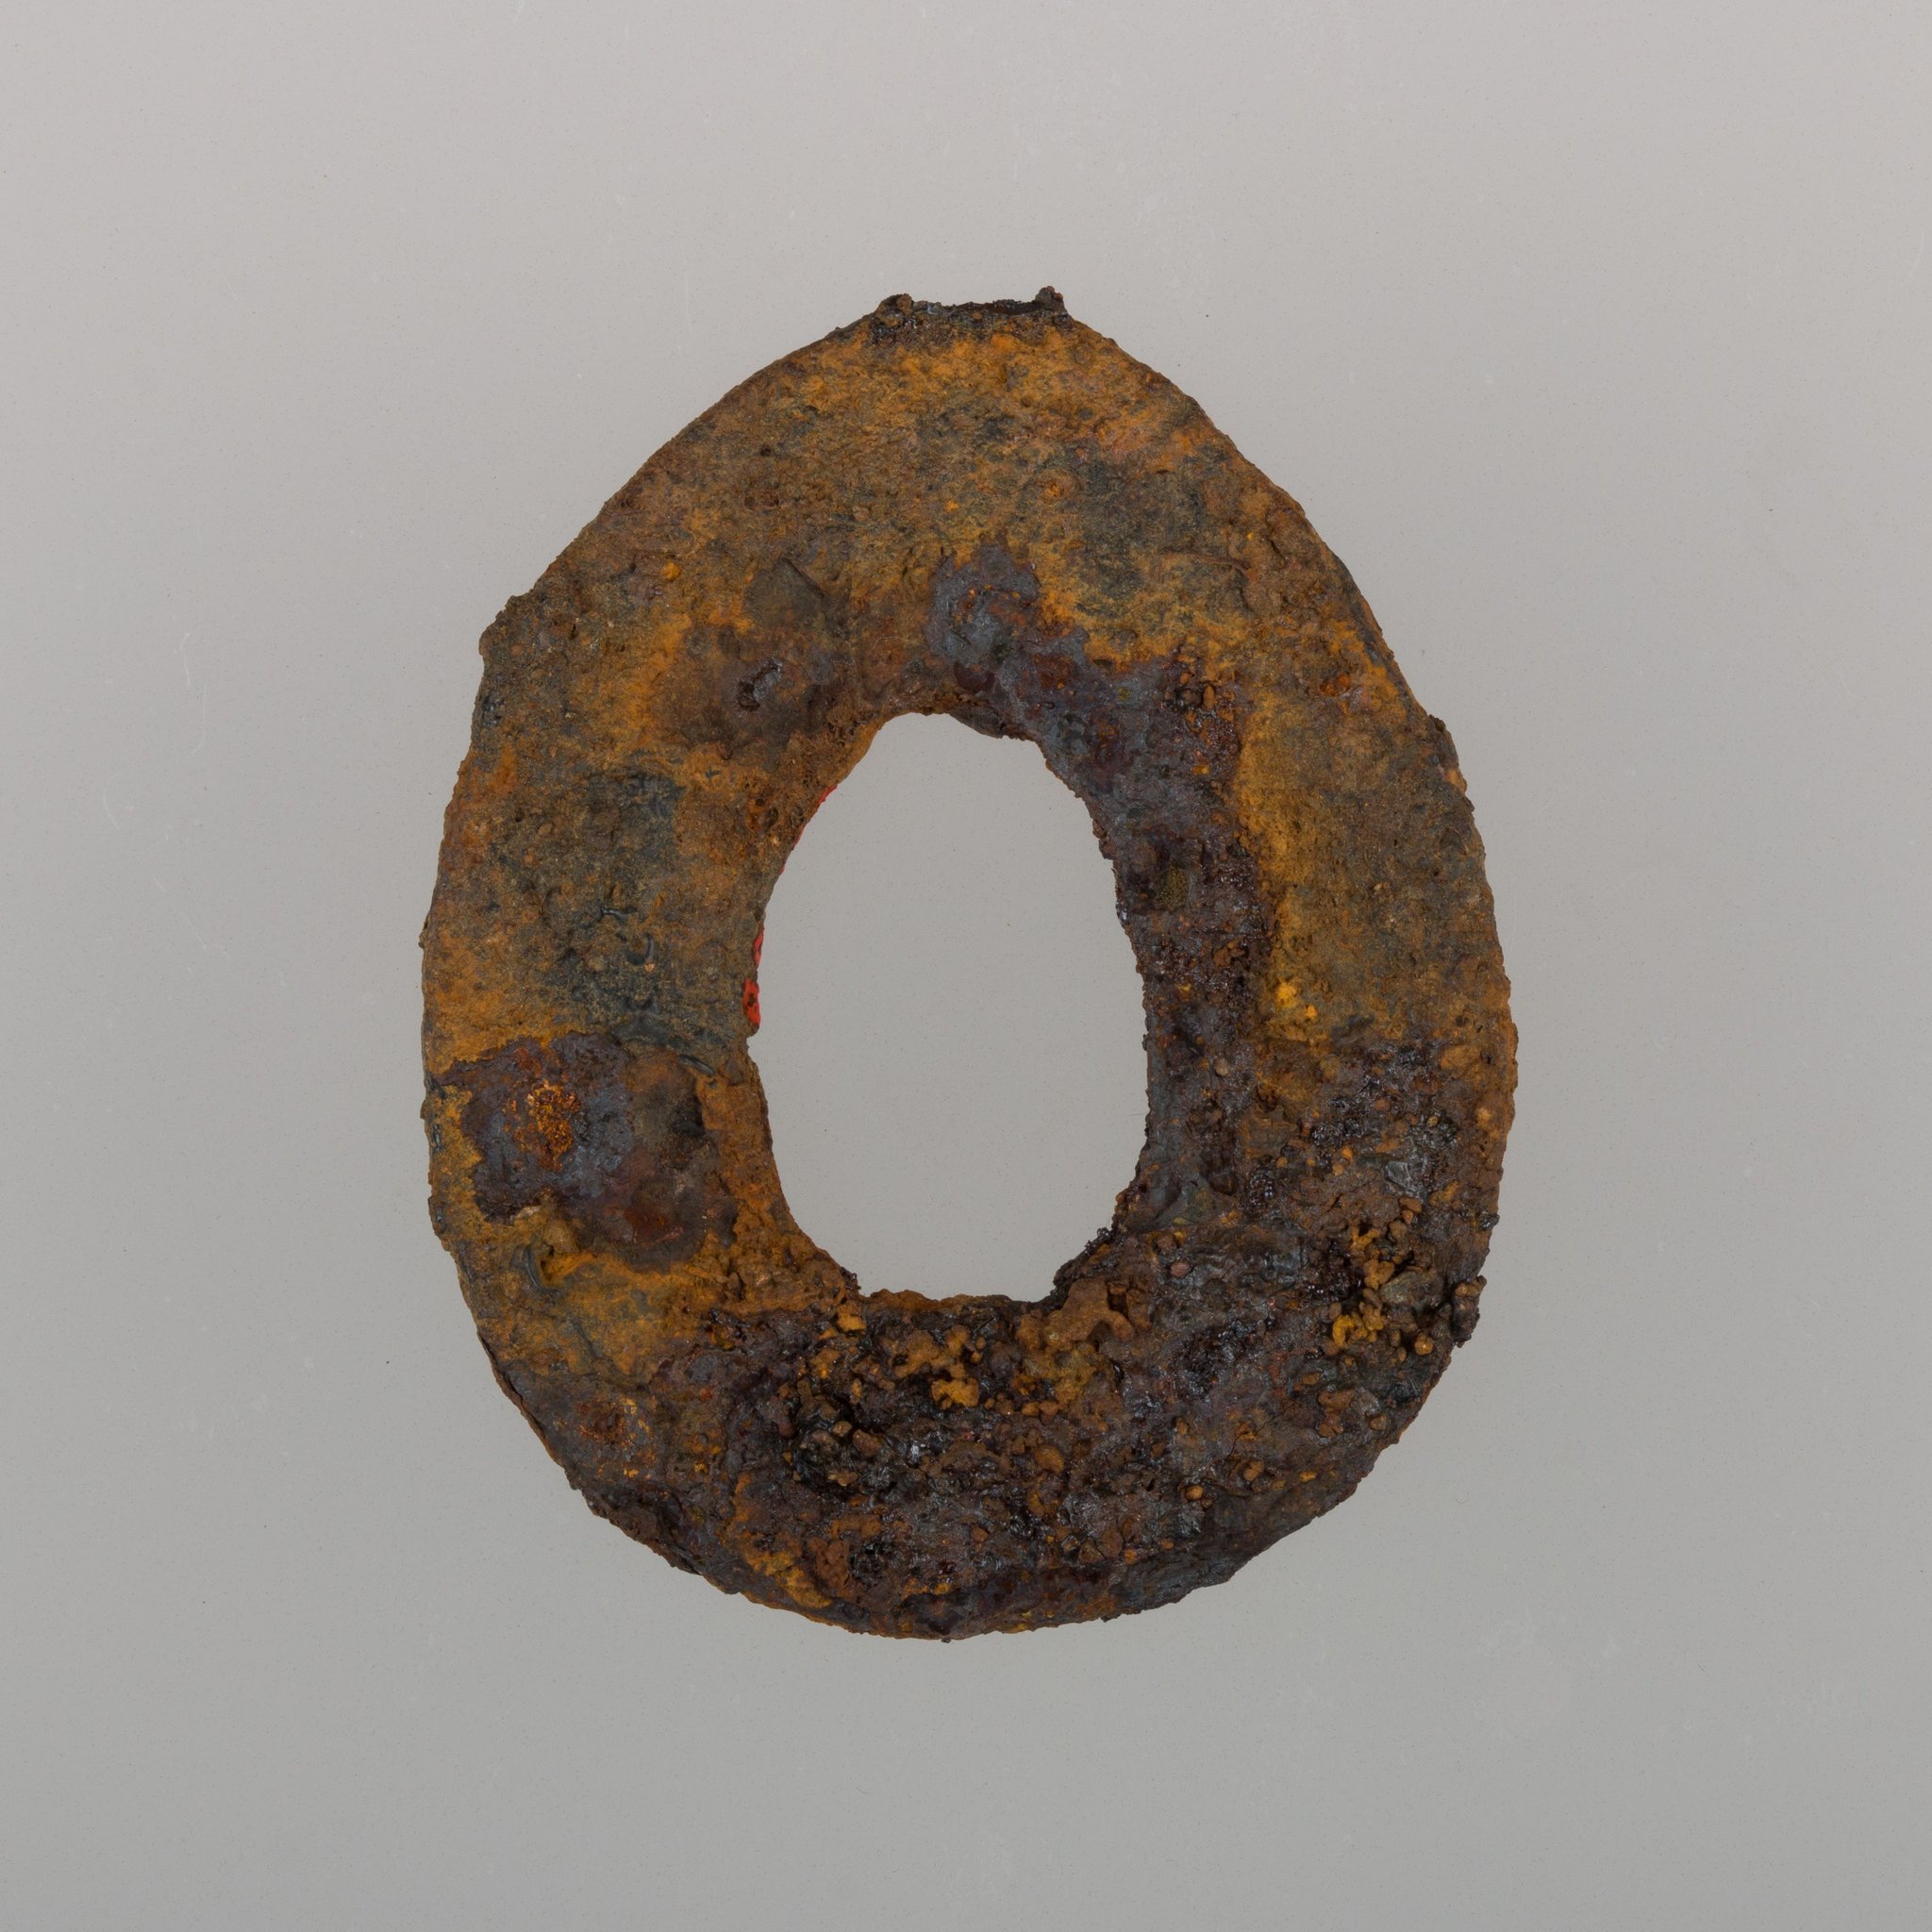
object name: sword guard tsuba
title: Sword Guard (Tsuba)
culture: japanese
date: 201-300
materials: iron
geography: japan